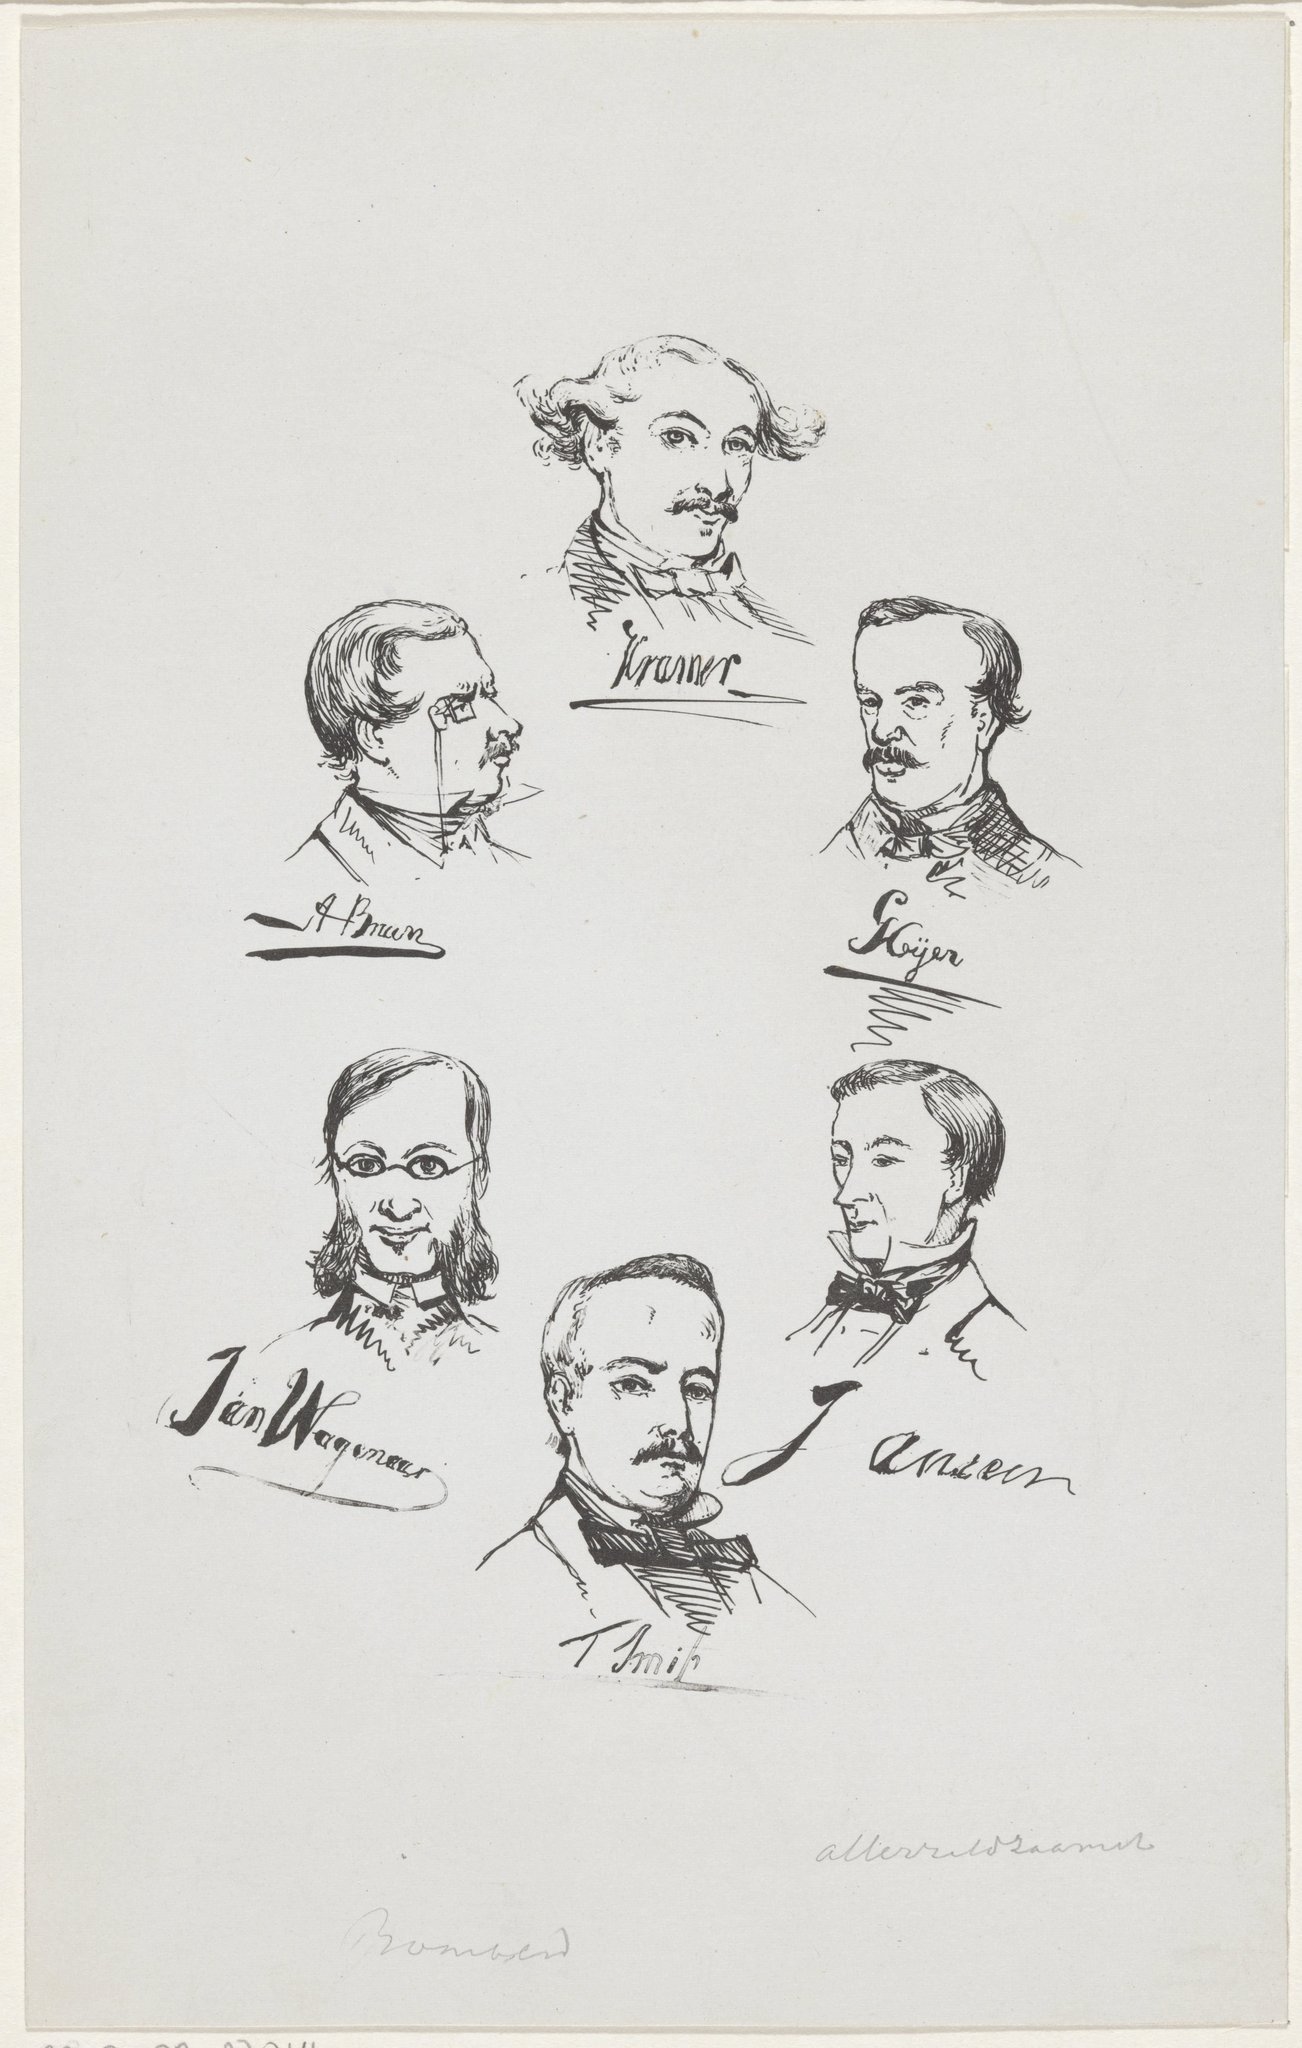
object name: print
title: Zes portretten van mannen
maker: karel frederik bombled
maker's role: draughtsman, print maker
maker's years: 1822-1902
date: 1832-1902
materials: paper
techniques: lithograph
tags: historical persons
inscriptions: inscription: ‘allerzeldzaamst’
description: De portretbustes zijn in een cirkel geplaatst. Onder ieder portret de naam van de geportretteerde.